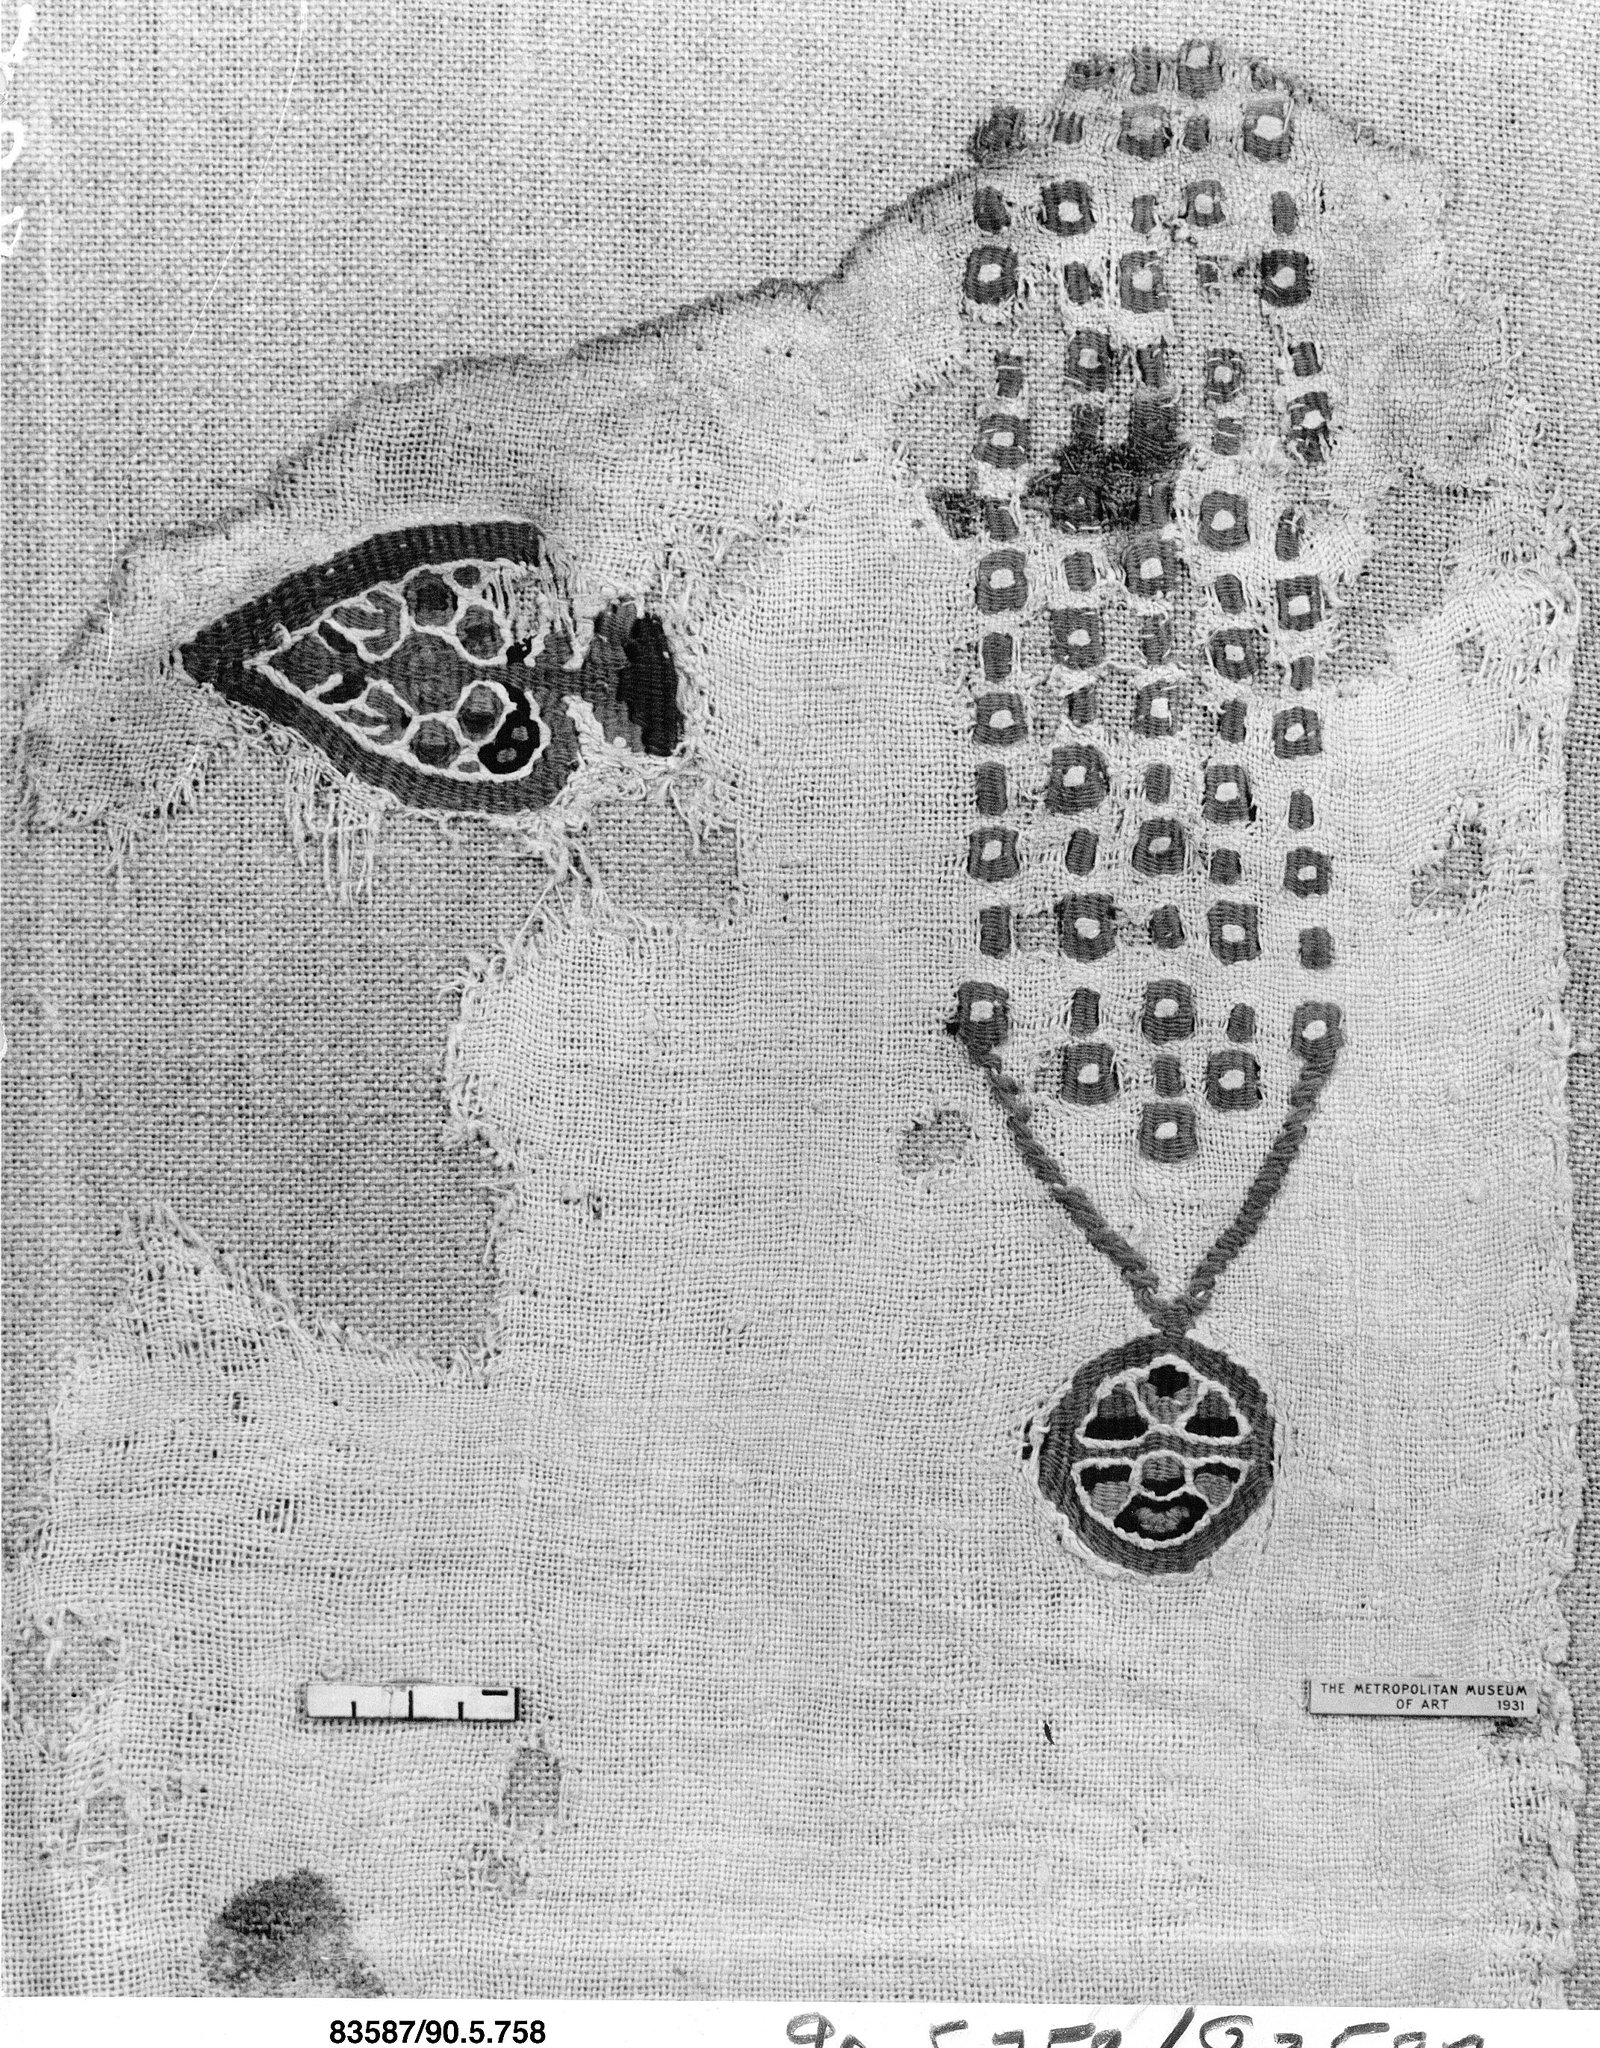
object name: textile fragment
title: Fragment of a Tunic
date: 401-600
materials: linen, wool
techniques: weave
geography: egypt